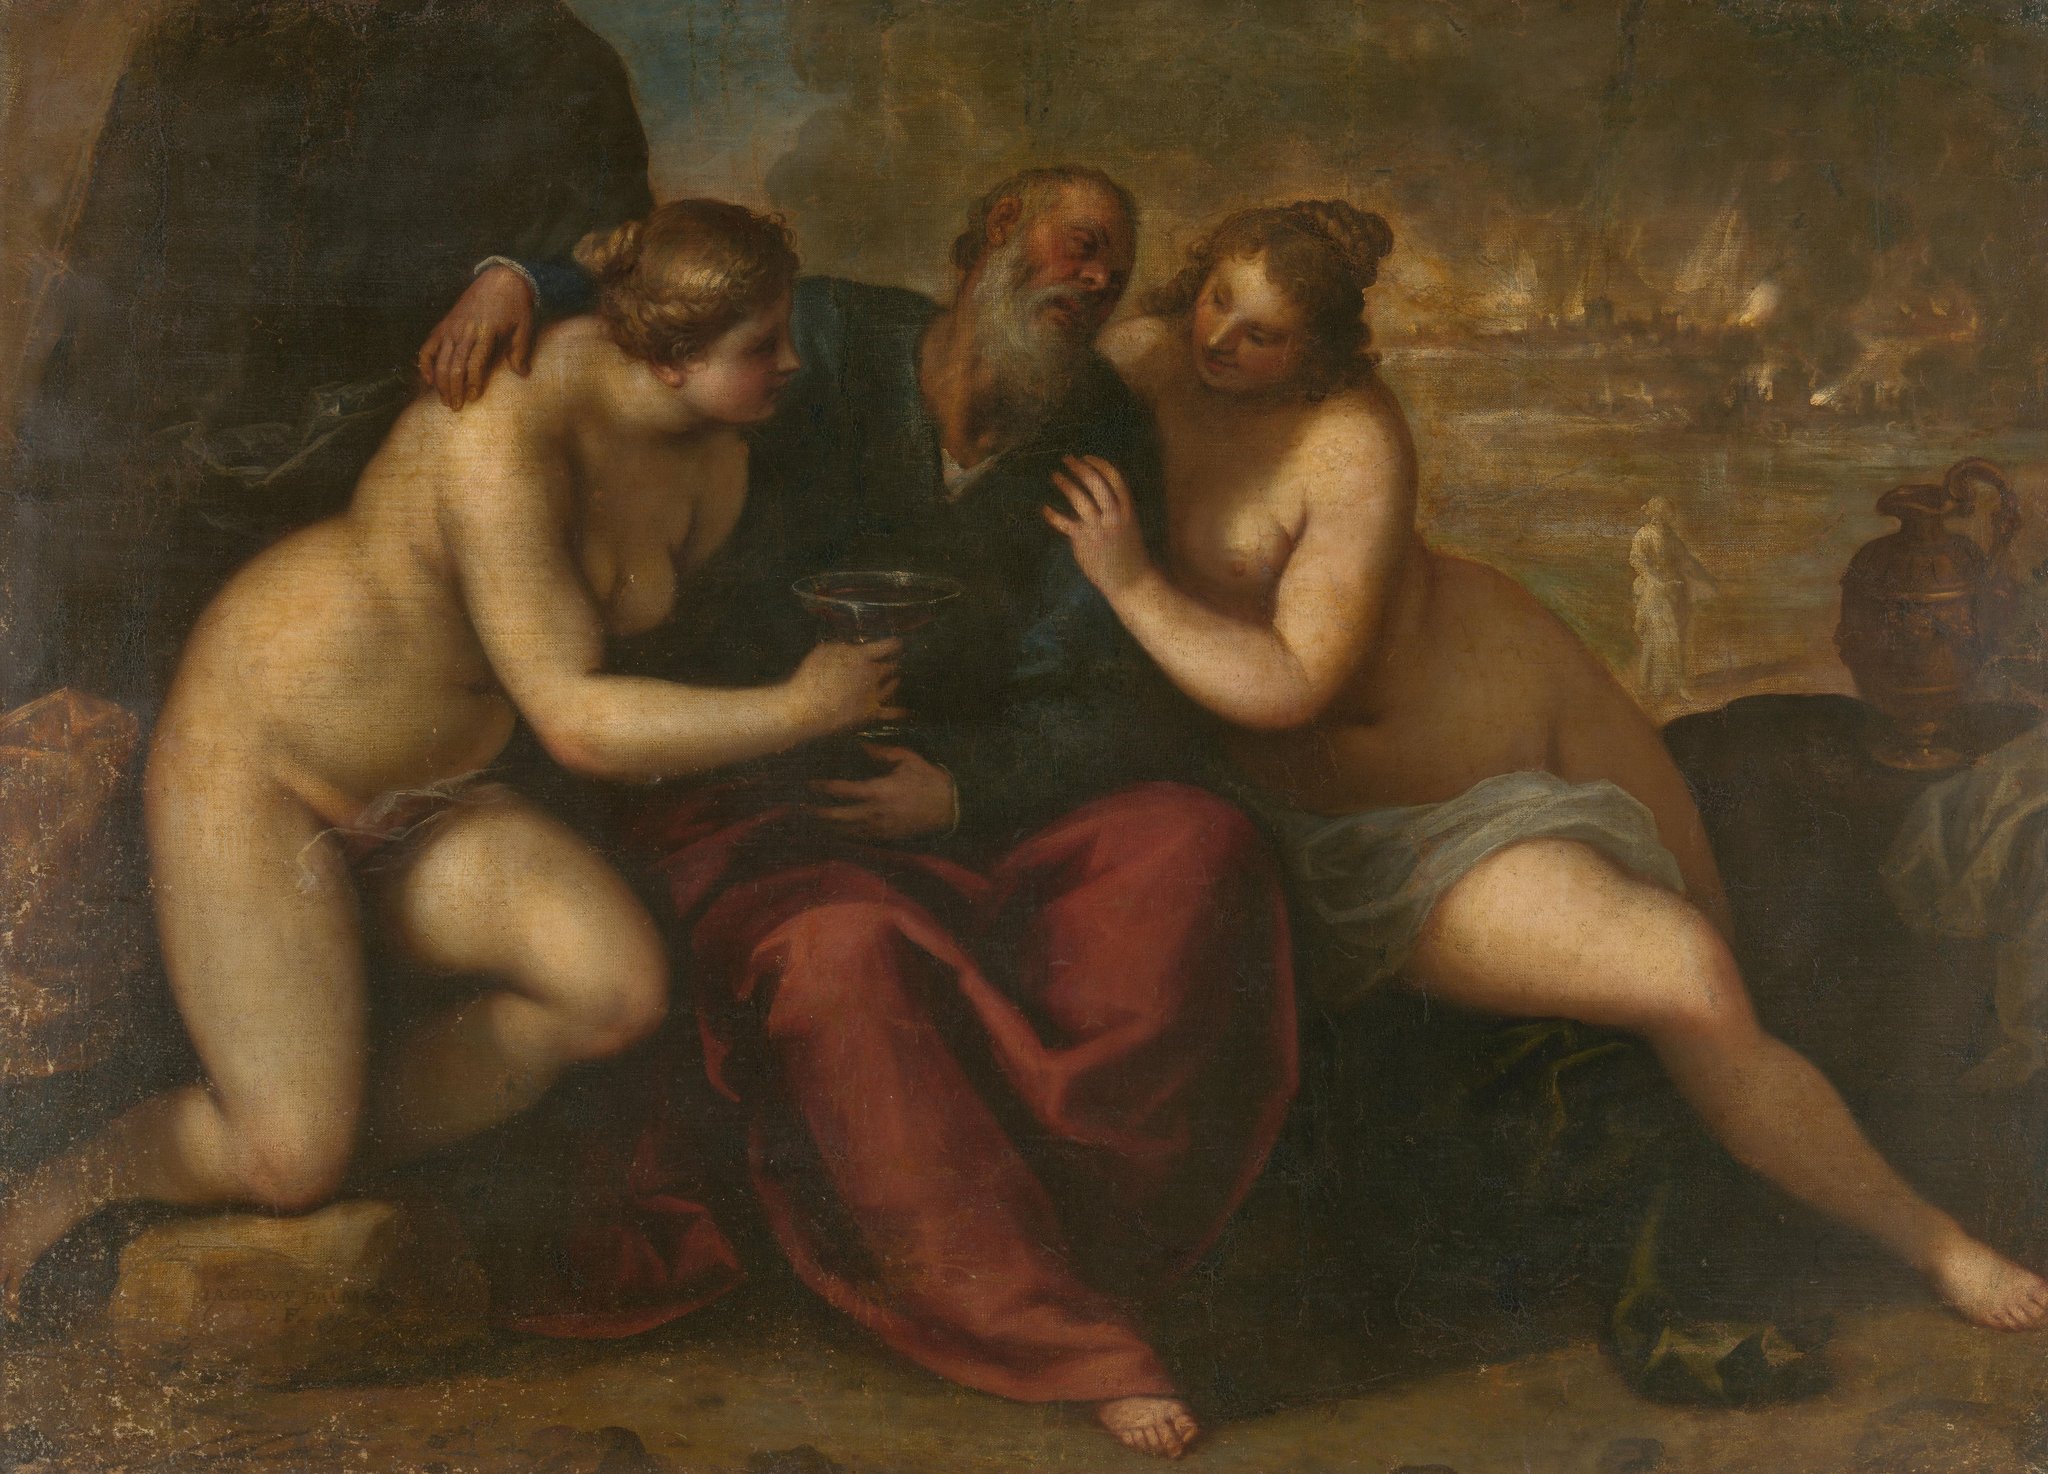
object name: painting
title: Lot and his Daughters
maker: jacopo palma (il giovane)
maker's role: draughtsman, painter, print maker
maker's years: 1544-1628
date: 1610-1620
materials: canvas, oil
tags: lot's daughters make their father drunk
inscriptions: signature: ‘Jacobus Palma .F.’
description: Lot wordt dronken gevoerd door zijn dochters. Zittend op rotsen in een landschap krijgt Lot van zijn twee naakte dochters een drinkschaal aangereikt, rechts op een rots staat de wijnkan. Op de achtergrond de vrouw van Lot als zoutpilaar voor de brandende steden Sodom en Gomorra.